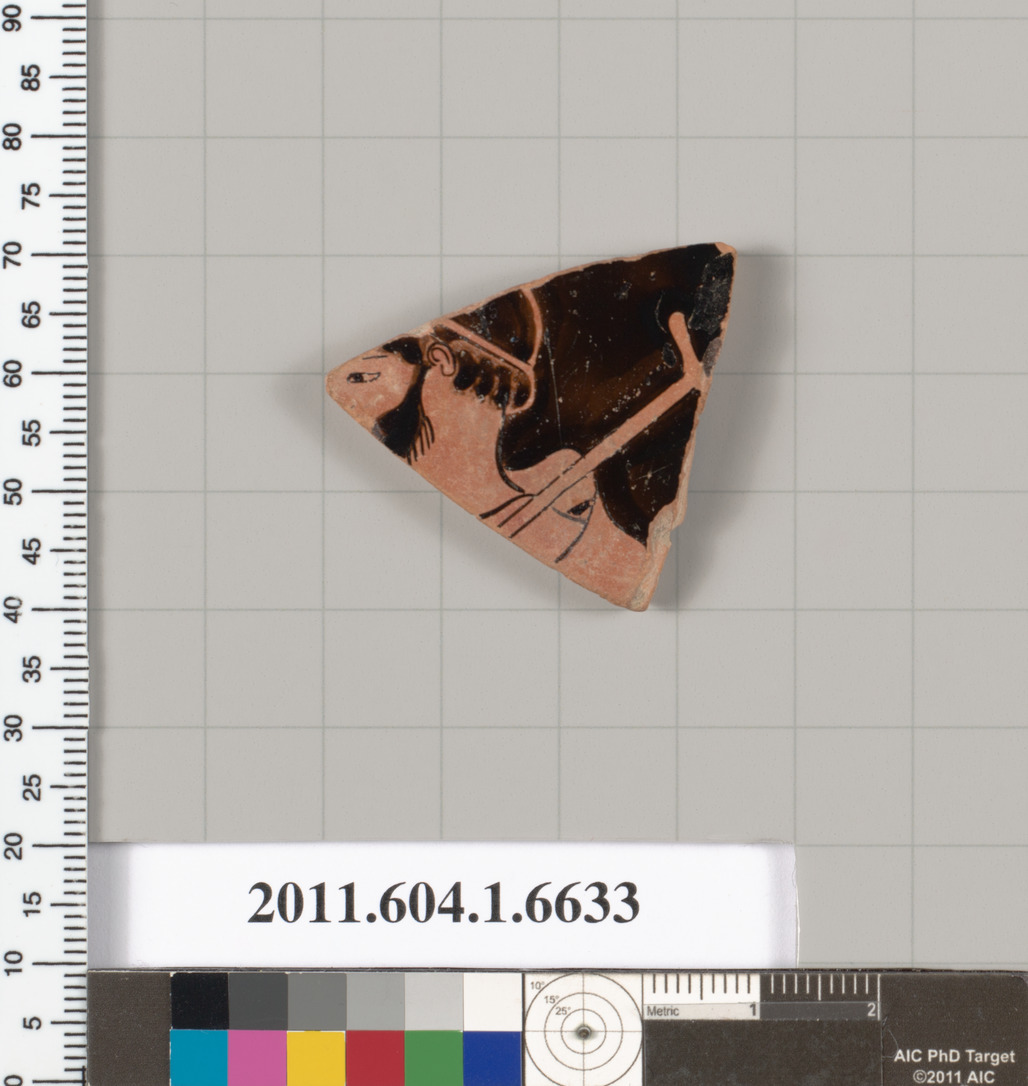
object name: kylix fragment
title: Terracotta fragment of a kylix (drinking cup)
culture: greek, attic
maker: briseis painter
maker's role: artist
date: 490-470 BCE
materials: terracotta